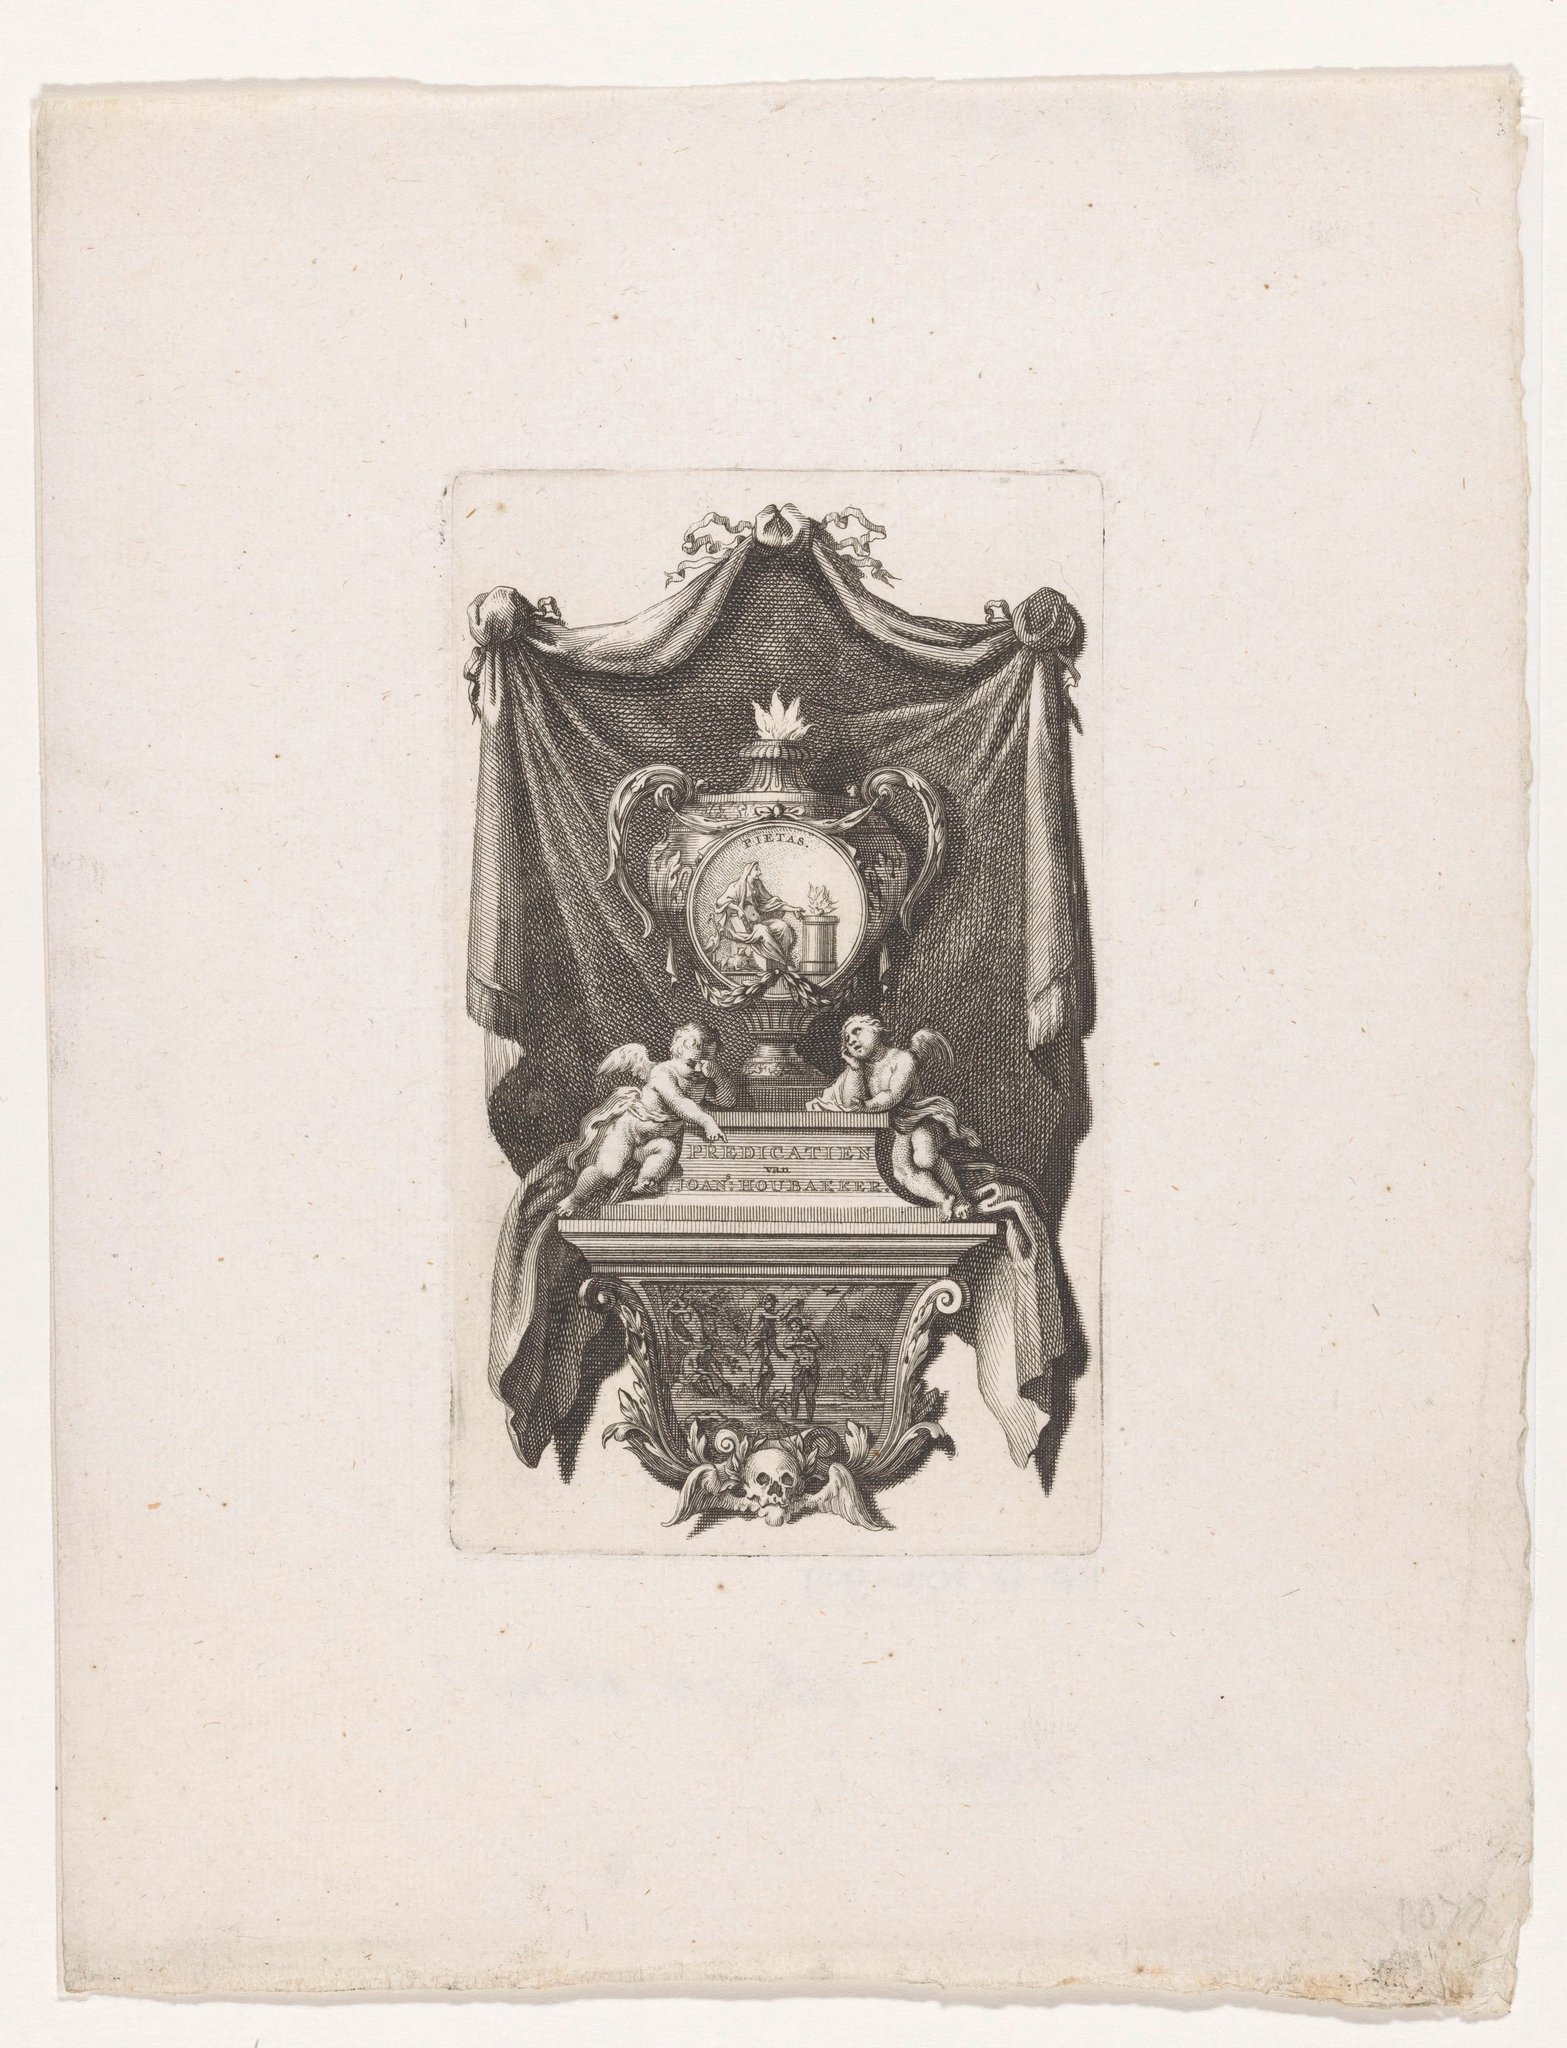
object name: titelblad, titelpagina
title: Predicatien van Joans: Houbakker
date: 1730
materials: paper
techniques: etching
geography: amsterdam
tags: pietas as roman personification, vase ~ ornament, pedestal of a piece of sculpture (perhaps in the form of a herm), cupids: 'amores', 'amoretti', 'putti'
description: Een geornamenteerde vaas met afbeelding van Vroomheid (Pietas) zittend naast een brandend altaar. De vaas staat op een voetstuk waarop twee putti zitten. Aan de onderzijde een afbeelding van de doop van Christus. Achter het geheel een draperie.